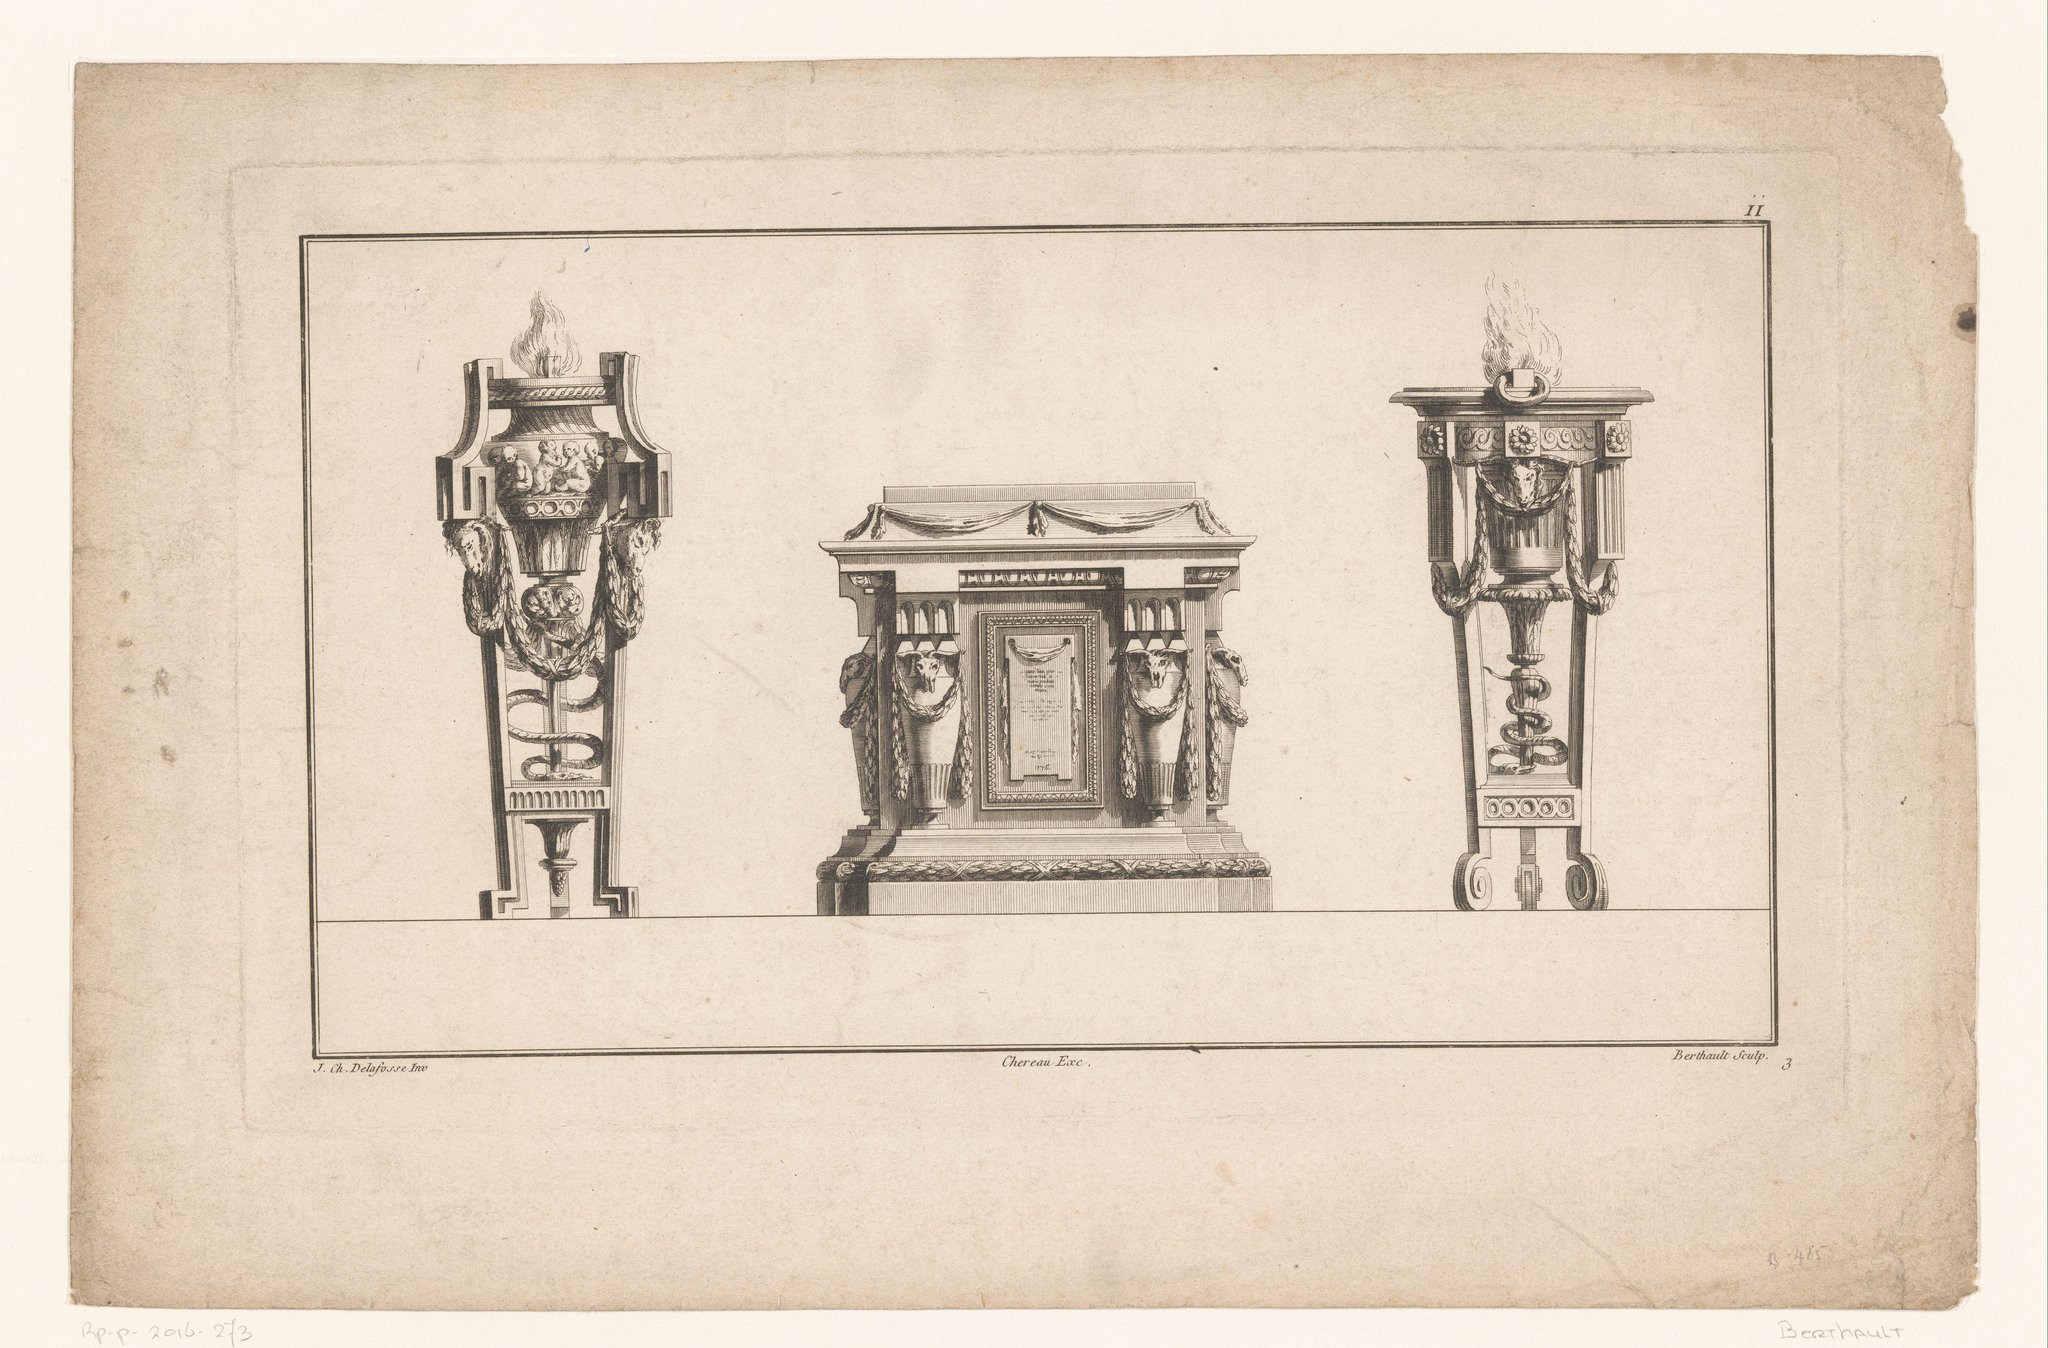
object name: print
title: IIe Volume De l'Oeuvre de J. Ch. Delafosse (...)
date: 1771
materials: paper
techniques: engraving, etching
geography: paris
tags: tripod, pedestal of a piece of sculpture (perhaps in the form of a herm)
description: Twee geornamenteerde Athéniennes (driepoten) met vuur aan weerszijden van een voetstuk met vazen en bucraniums.